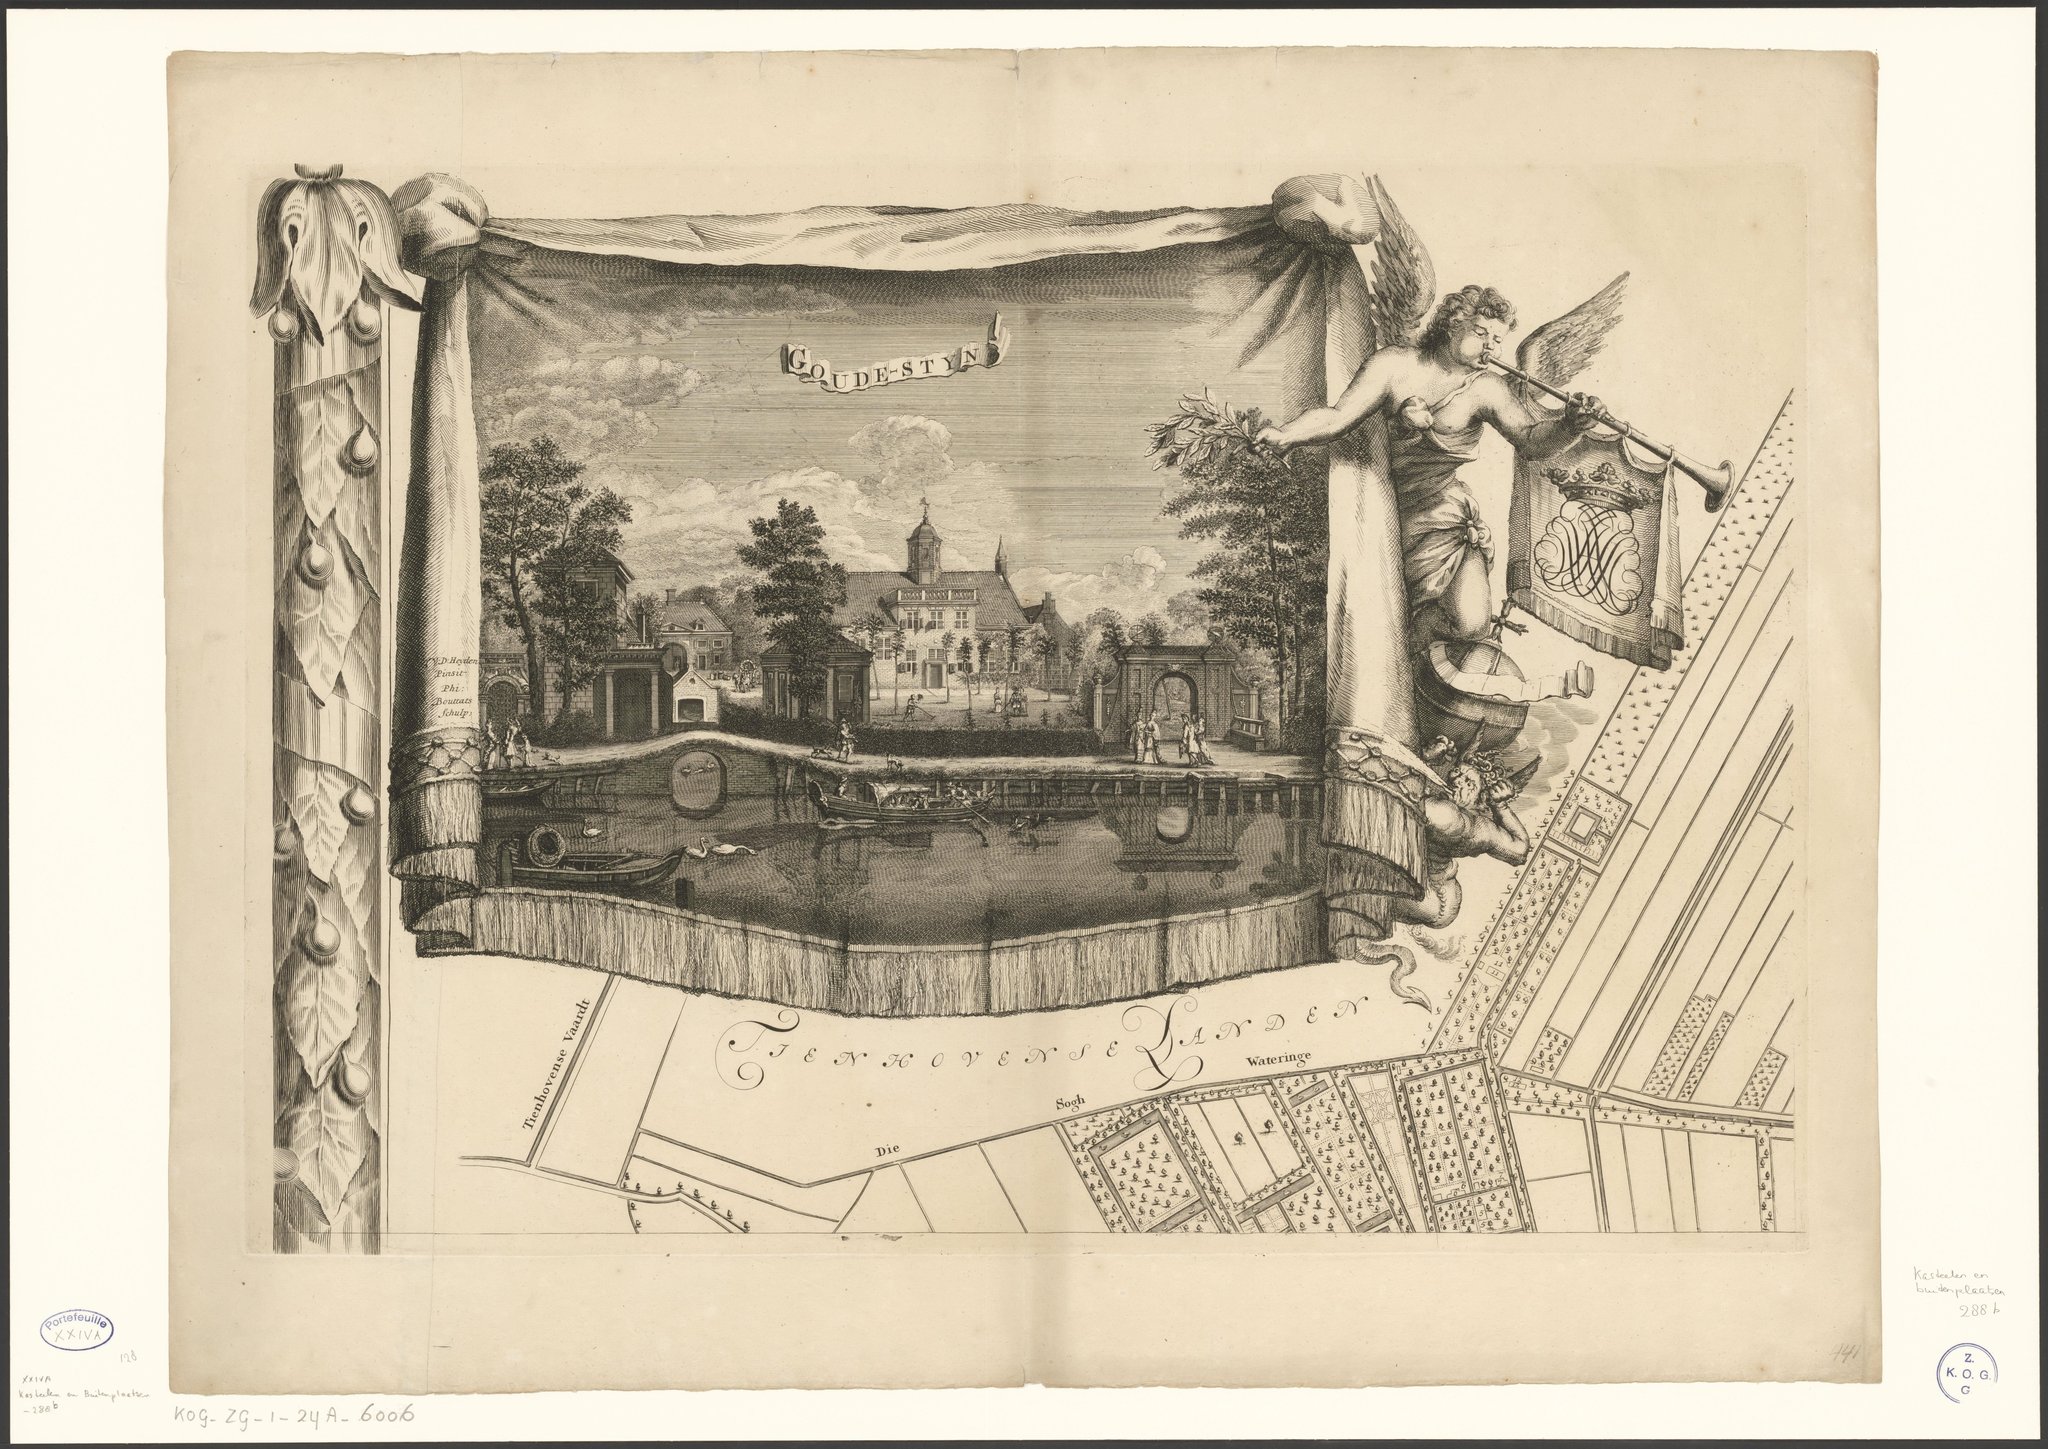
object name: print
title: Een gedeelte van de heerlyckheyt van Maerseveen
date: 1690-1691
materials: paper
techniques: engraving, etching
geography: netherlands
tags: envy; 'invidia' (ripa) ~ personification of one of the seven deadly sins, human-shaped devil, fame; 'fama', 'fama buona', 'fama chiara' (ripa), maps of cities, farm or solitary house in landscape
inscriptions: collector's mark: Lugt 1641, collector's mark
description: Plaat linksboven. De plattegrond van een gedeelte van de heerlijkheid Maarsseveen. Een grote banderol met gezicht op Goudestein, een buitenplaats in de heerlijkheid Maarsseveen. Langs de rivier de Vecht wandelen verschillende paartjes en een herder. Op de rivier varen enkele bootjes en zwemmen zwanen. Op de achtergrond het buitenverblijf Goudenstein. Vanachter de banderol komt de allegorische figuur van Roem. Zij blaast op een trompet met een vaandel en verjaagt een duivel. Onderwerpsrubrieken binnen de Atlas Zeden en Gewoonten: Kastelen en buitenplaatsen; prenten van bijzonder groot formaat.